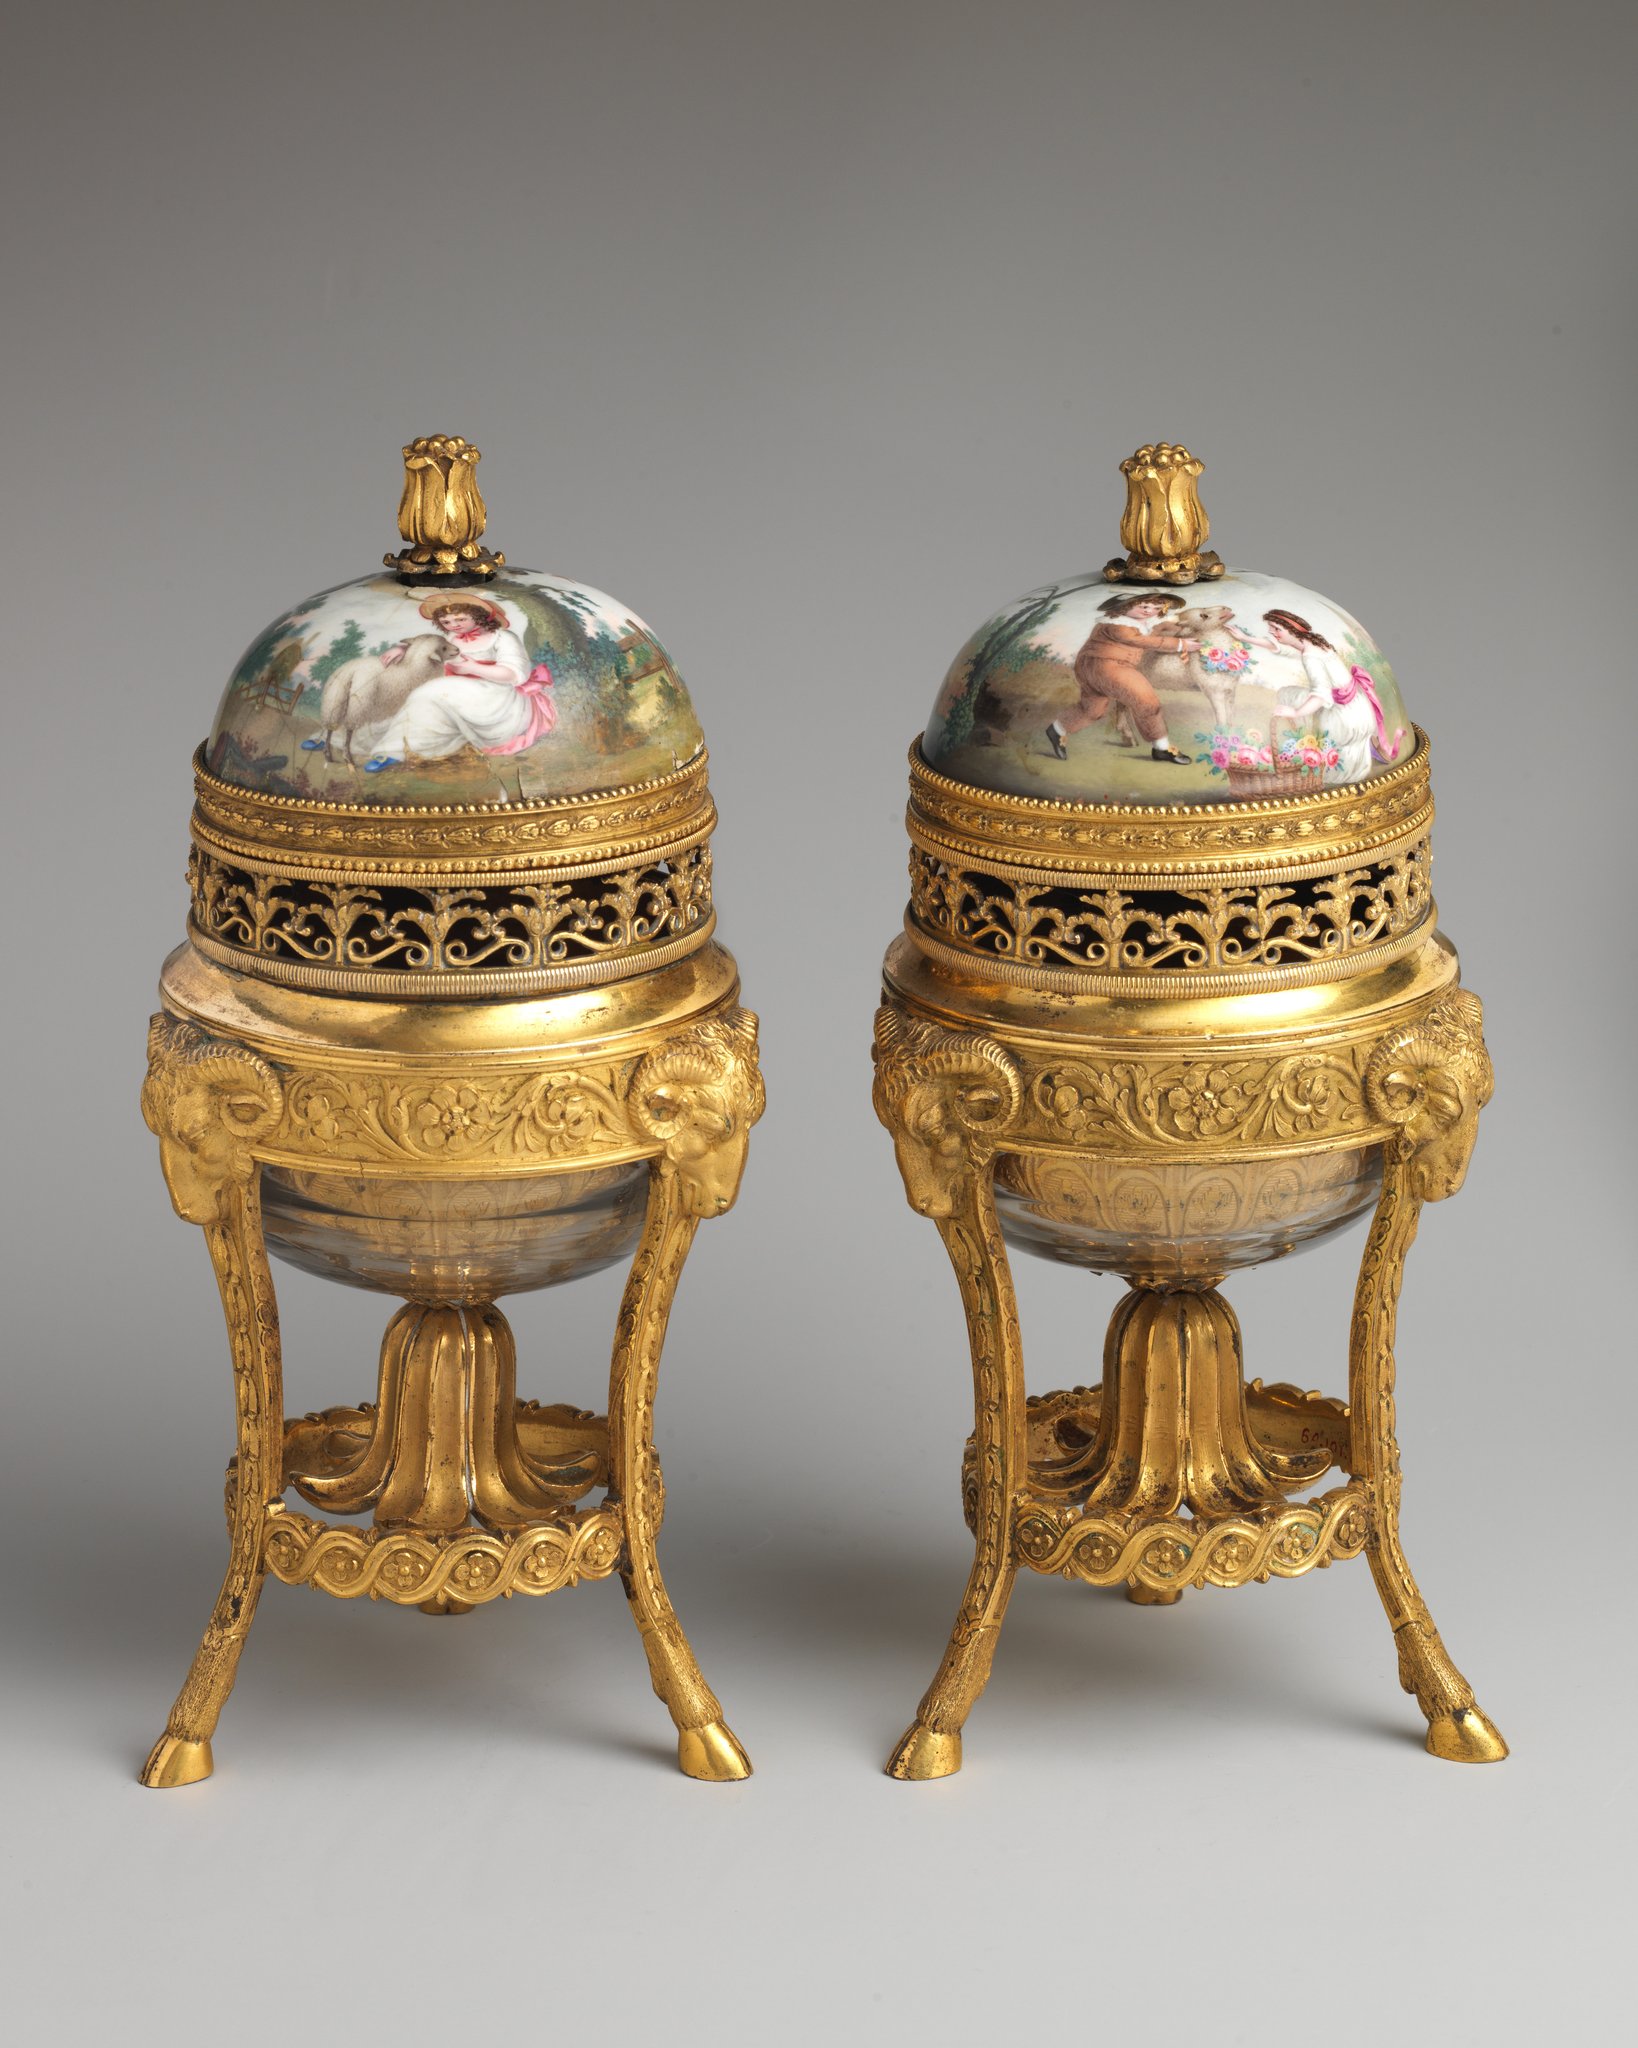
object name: cassolettes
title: Pair of cassolettes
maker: willliam hopkins croft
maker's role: enameler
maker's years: 1725-1825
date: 1787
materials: copper, enamel, gilt bronze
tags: boys,girls,sheep